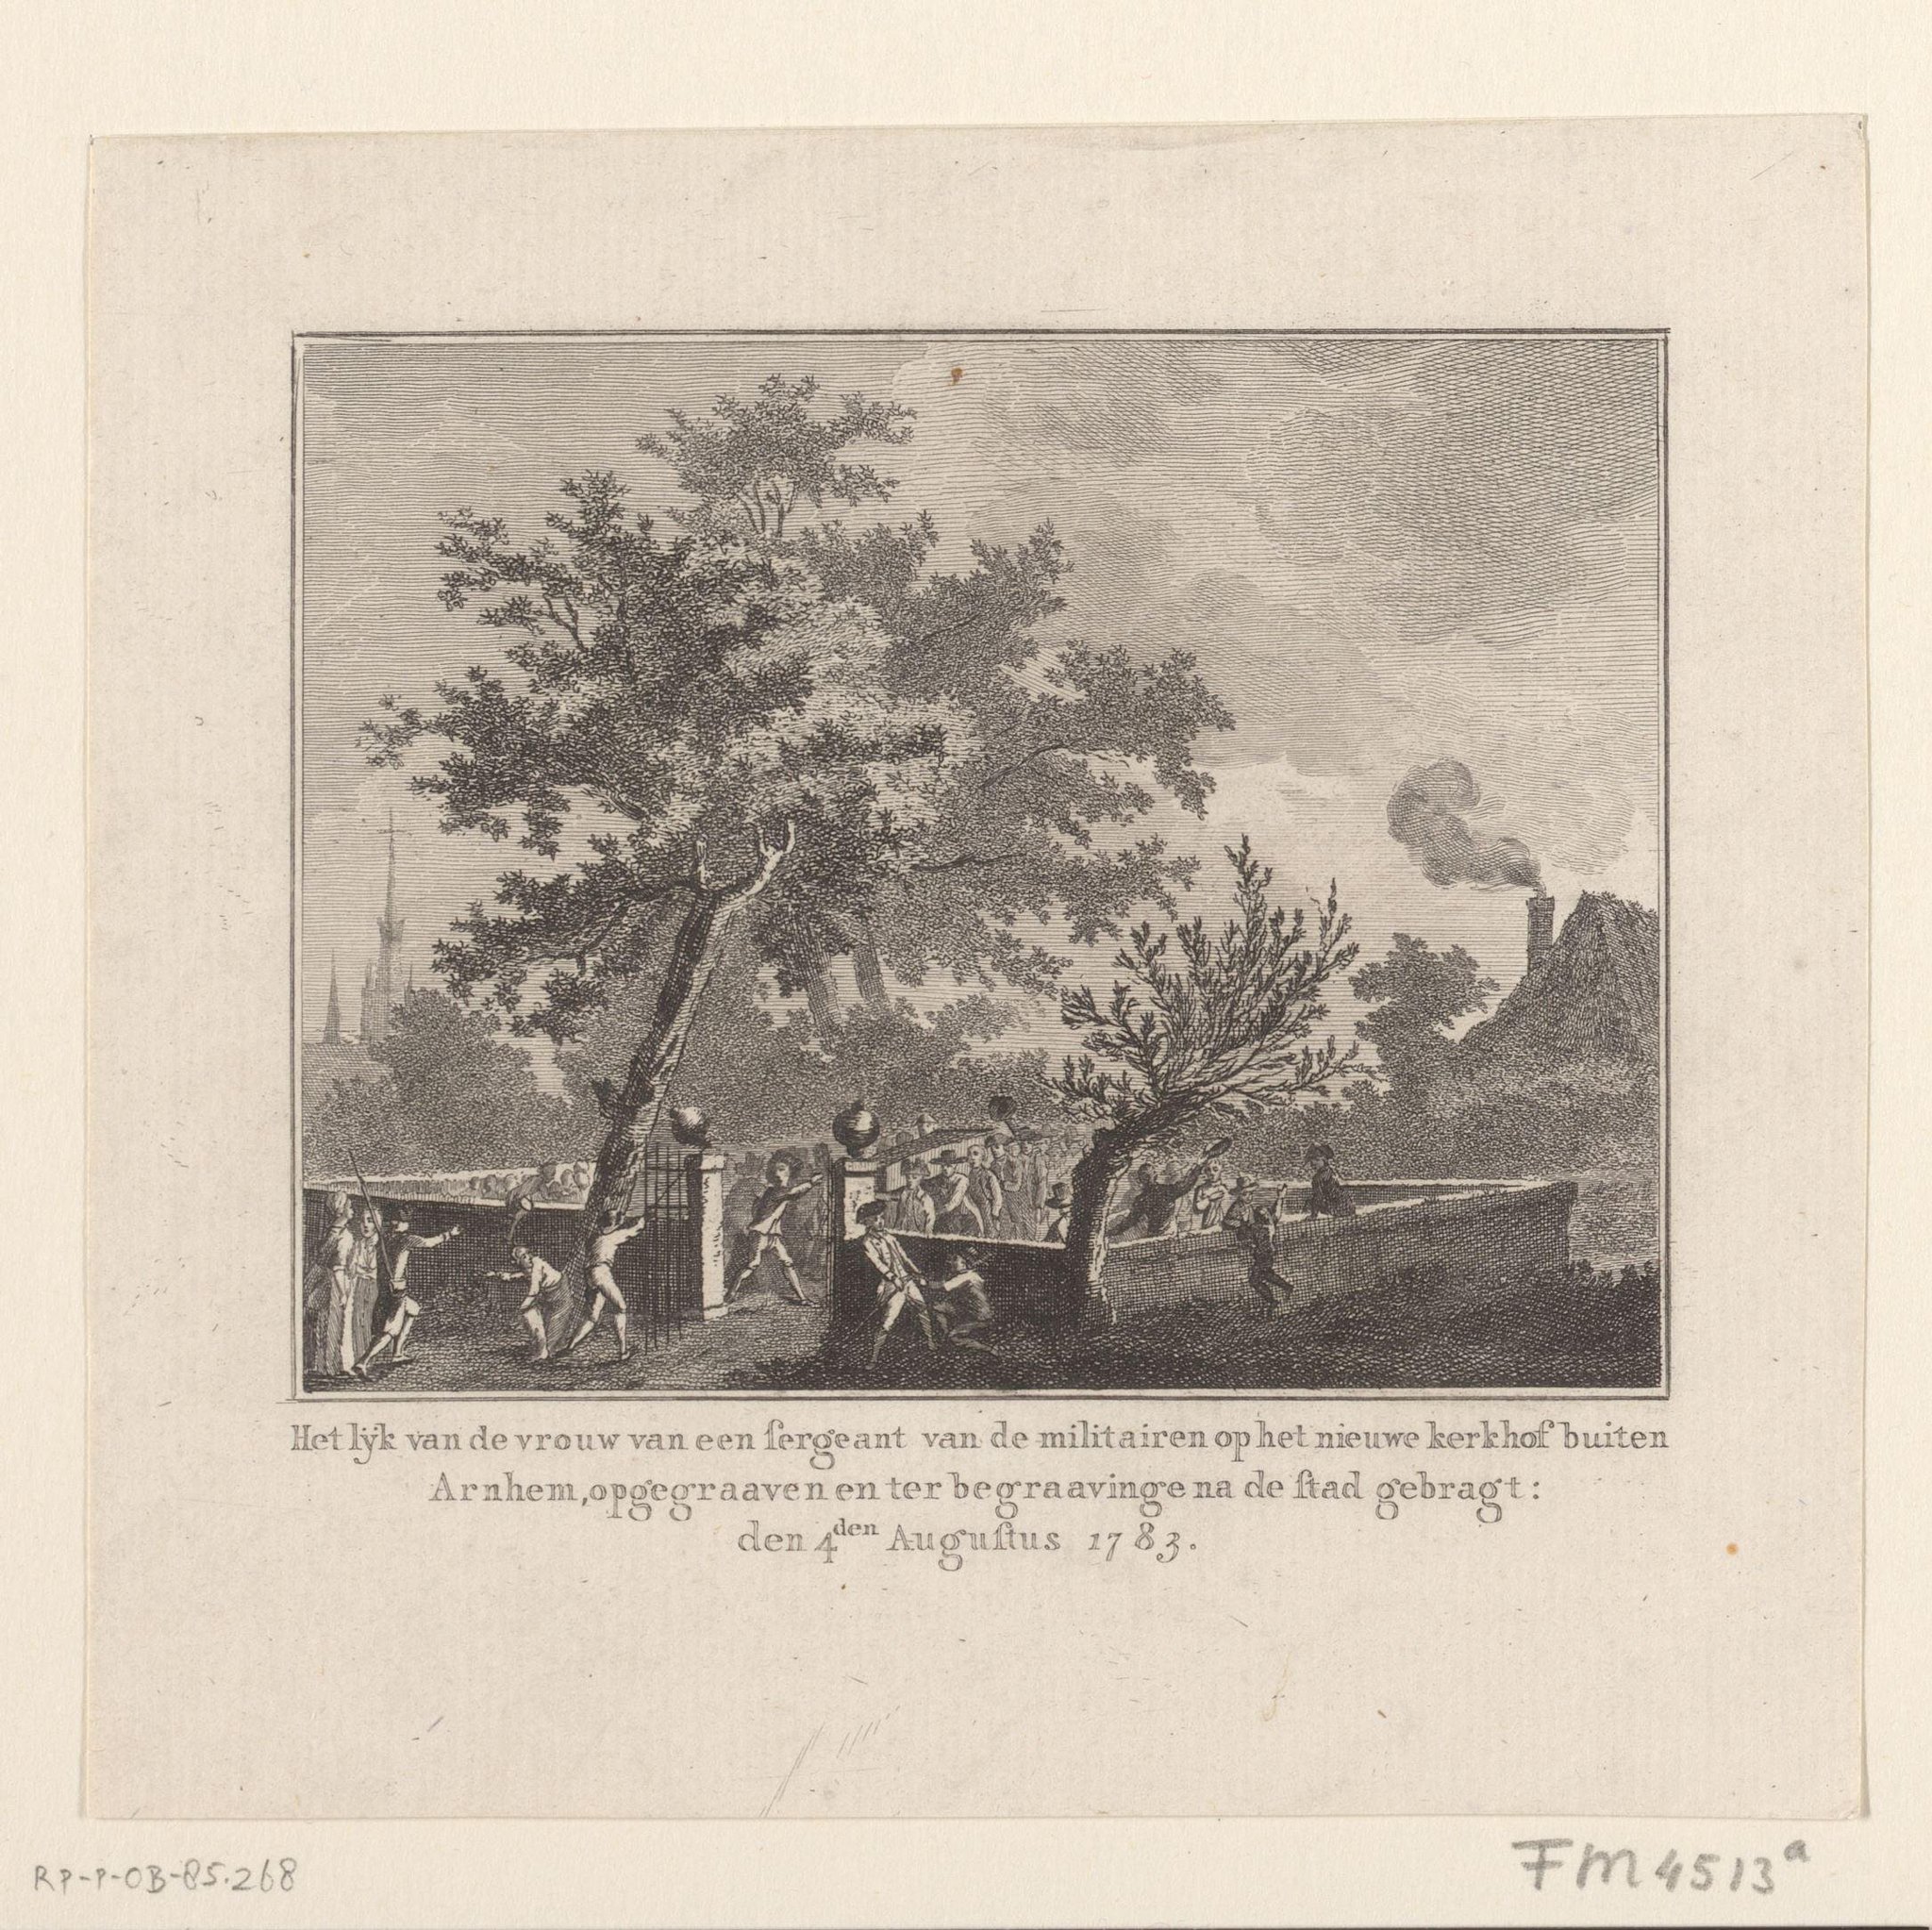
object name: print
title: Herbegrafenis van de vrouw te Arnhem, 1783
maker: mathias de sallieth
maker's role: print maker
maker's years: 1749-1791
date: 1787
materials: paper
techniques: engraving, etching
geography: northern netherlands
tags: opening of grave, exhumation, arnhem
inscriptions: collector's mark: Lugt 2228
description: Herbegrafenis van de vrouw te Arnhem, 4 augustus 1783. Fragment van een grotere plaat met de titel 'Atlas der Geschiedenissen van onzen tyd. Plaat I'. Dit was een proefaflevering van een nieuwe reeks voorstellingen van historische gebeurtenissen uit de jaren 1780-1787, de reeks is na dit eerste nummer niet voortgezet.